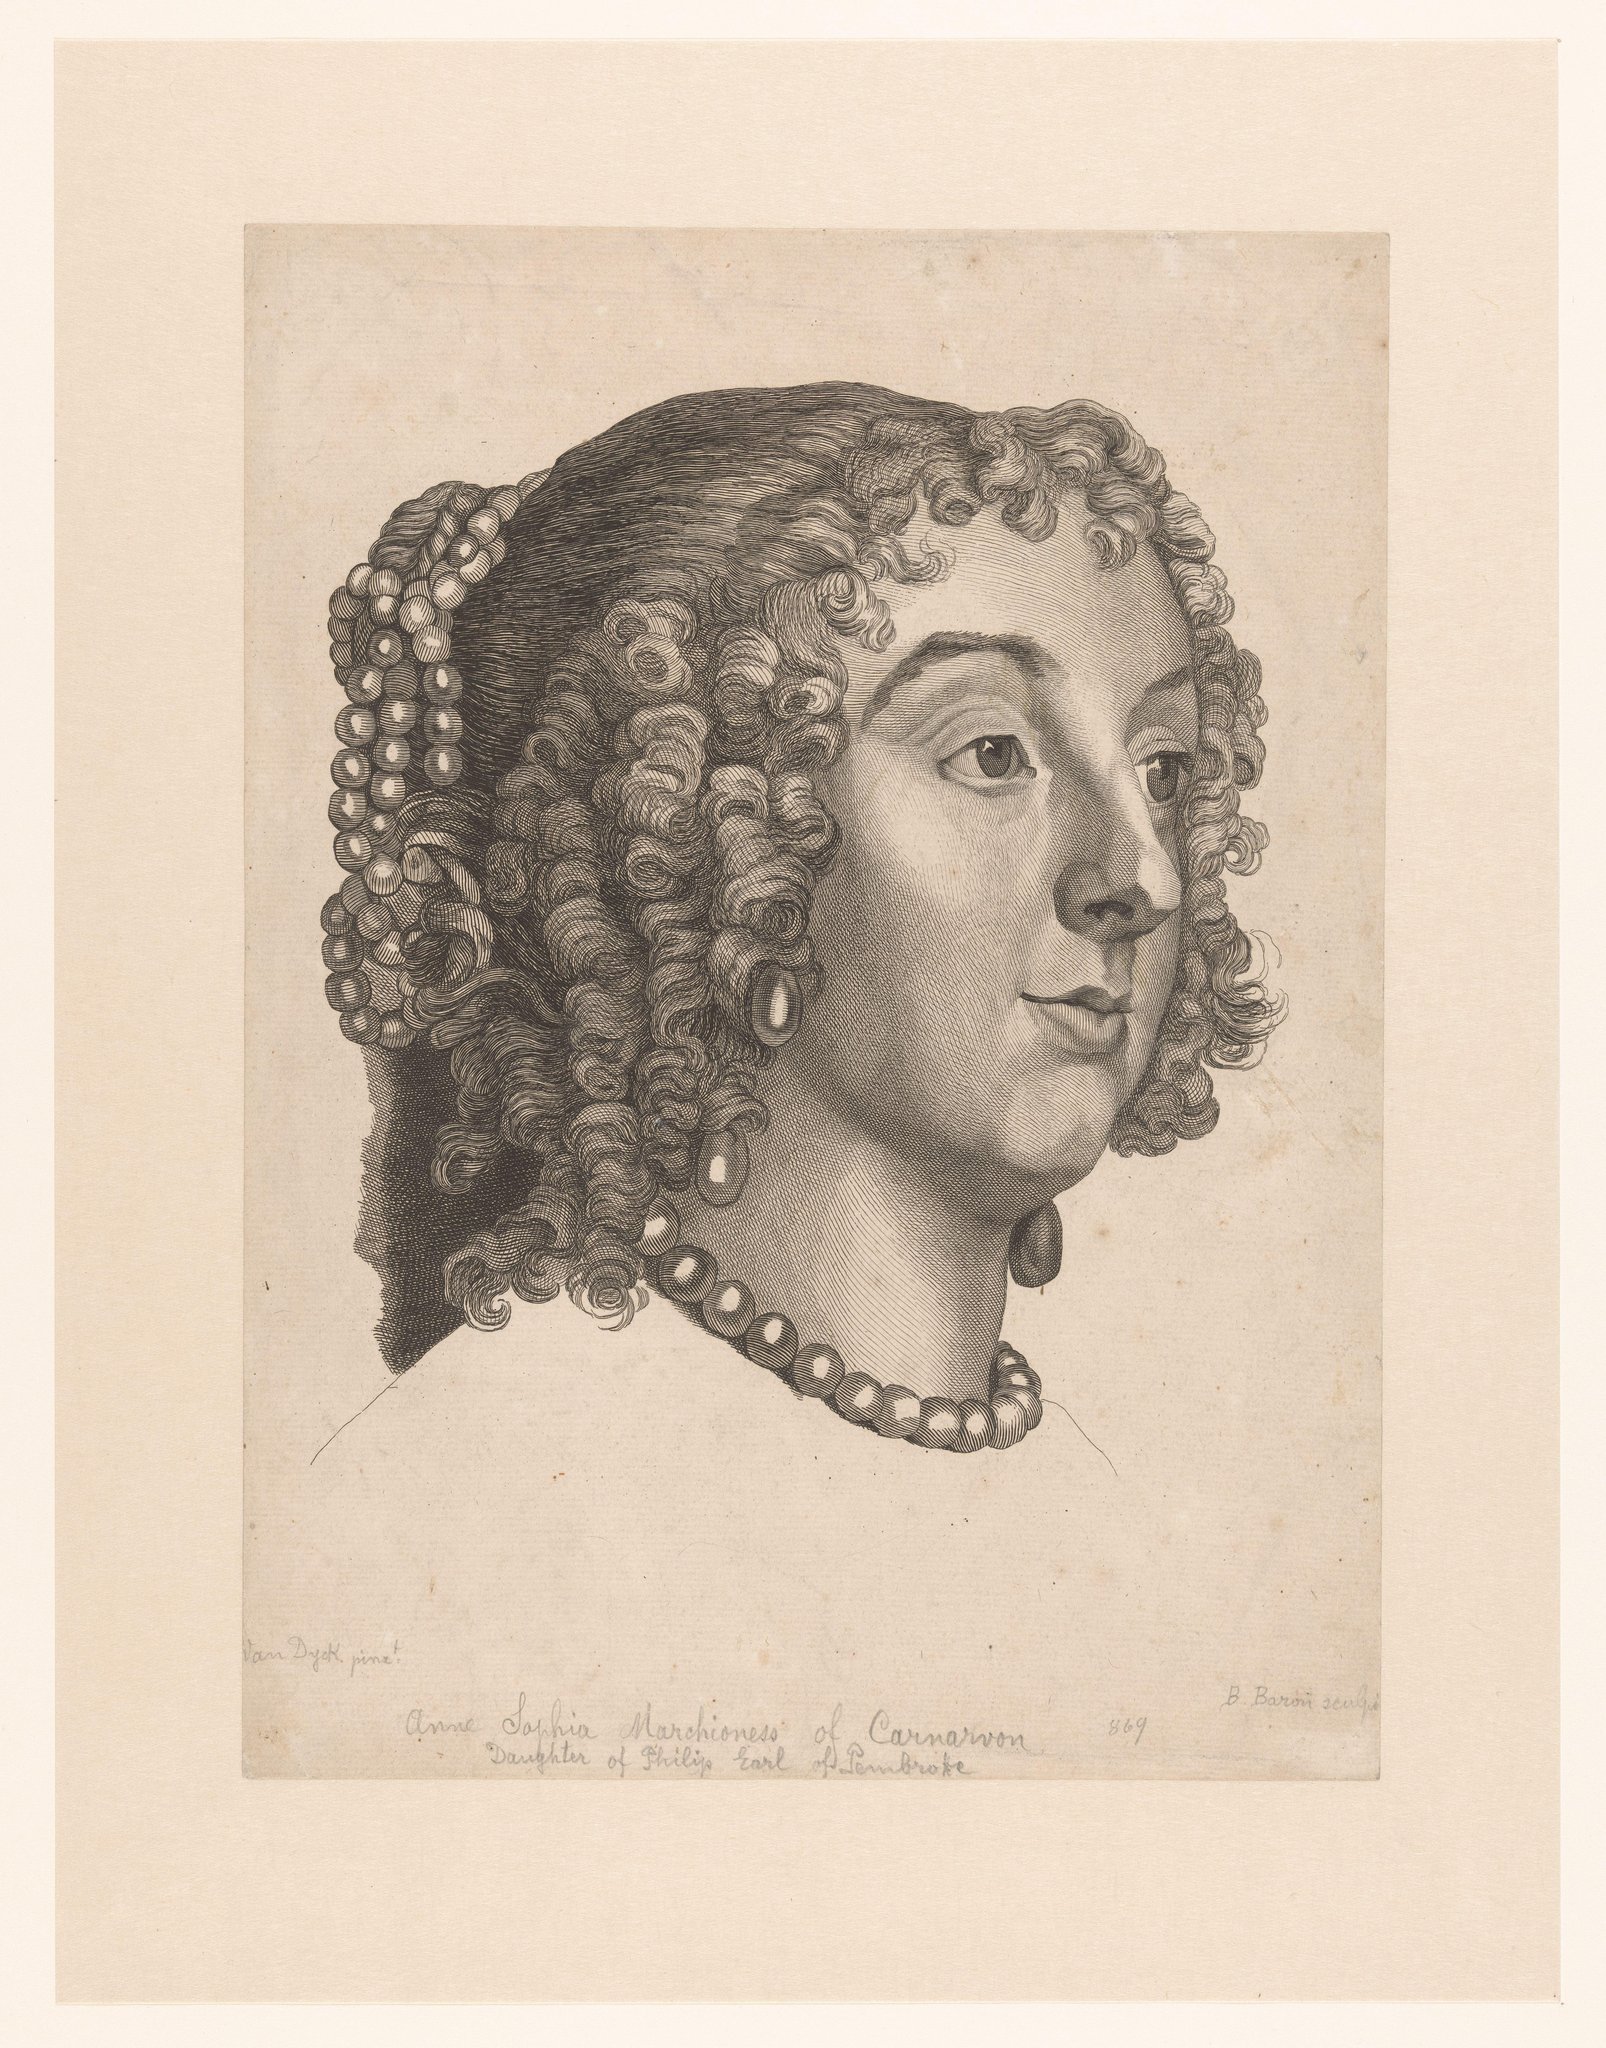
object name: print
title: Martelaarschap van de heilige Christoffel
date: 1776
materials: paper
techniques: etching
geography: padua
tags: martyrdom, suffering, misfortune, death of st. christopher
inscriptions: collector's mark: Lugt 2228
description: Prent uit een reeks van vier prenten (+ titelprent) met weergaven van de fresco's van Andrea Mategna in de Chiesa degli Eremitani in Padua (fresco's zijn vernietigd tijdens bombardement 11 maart 1944).